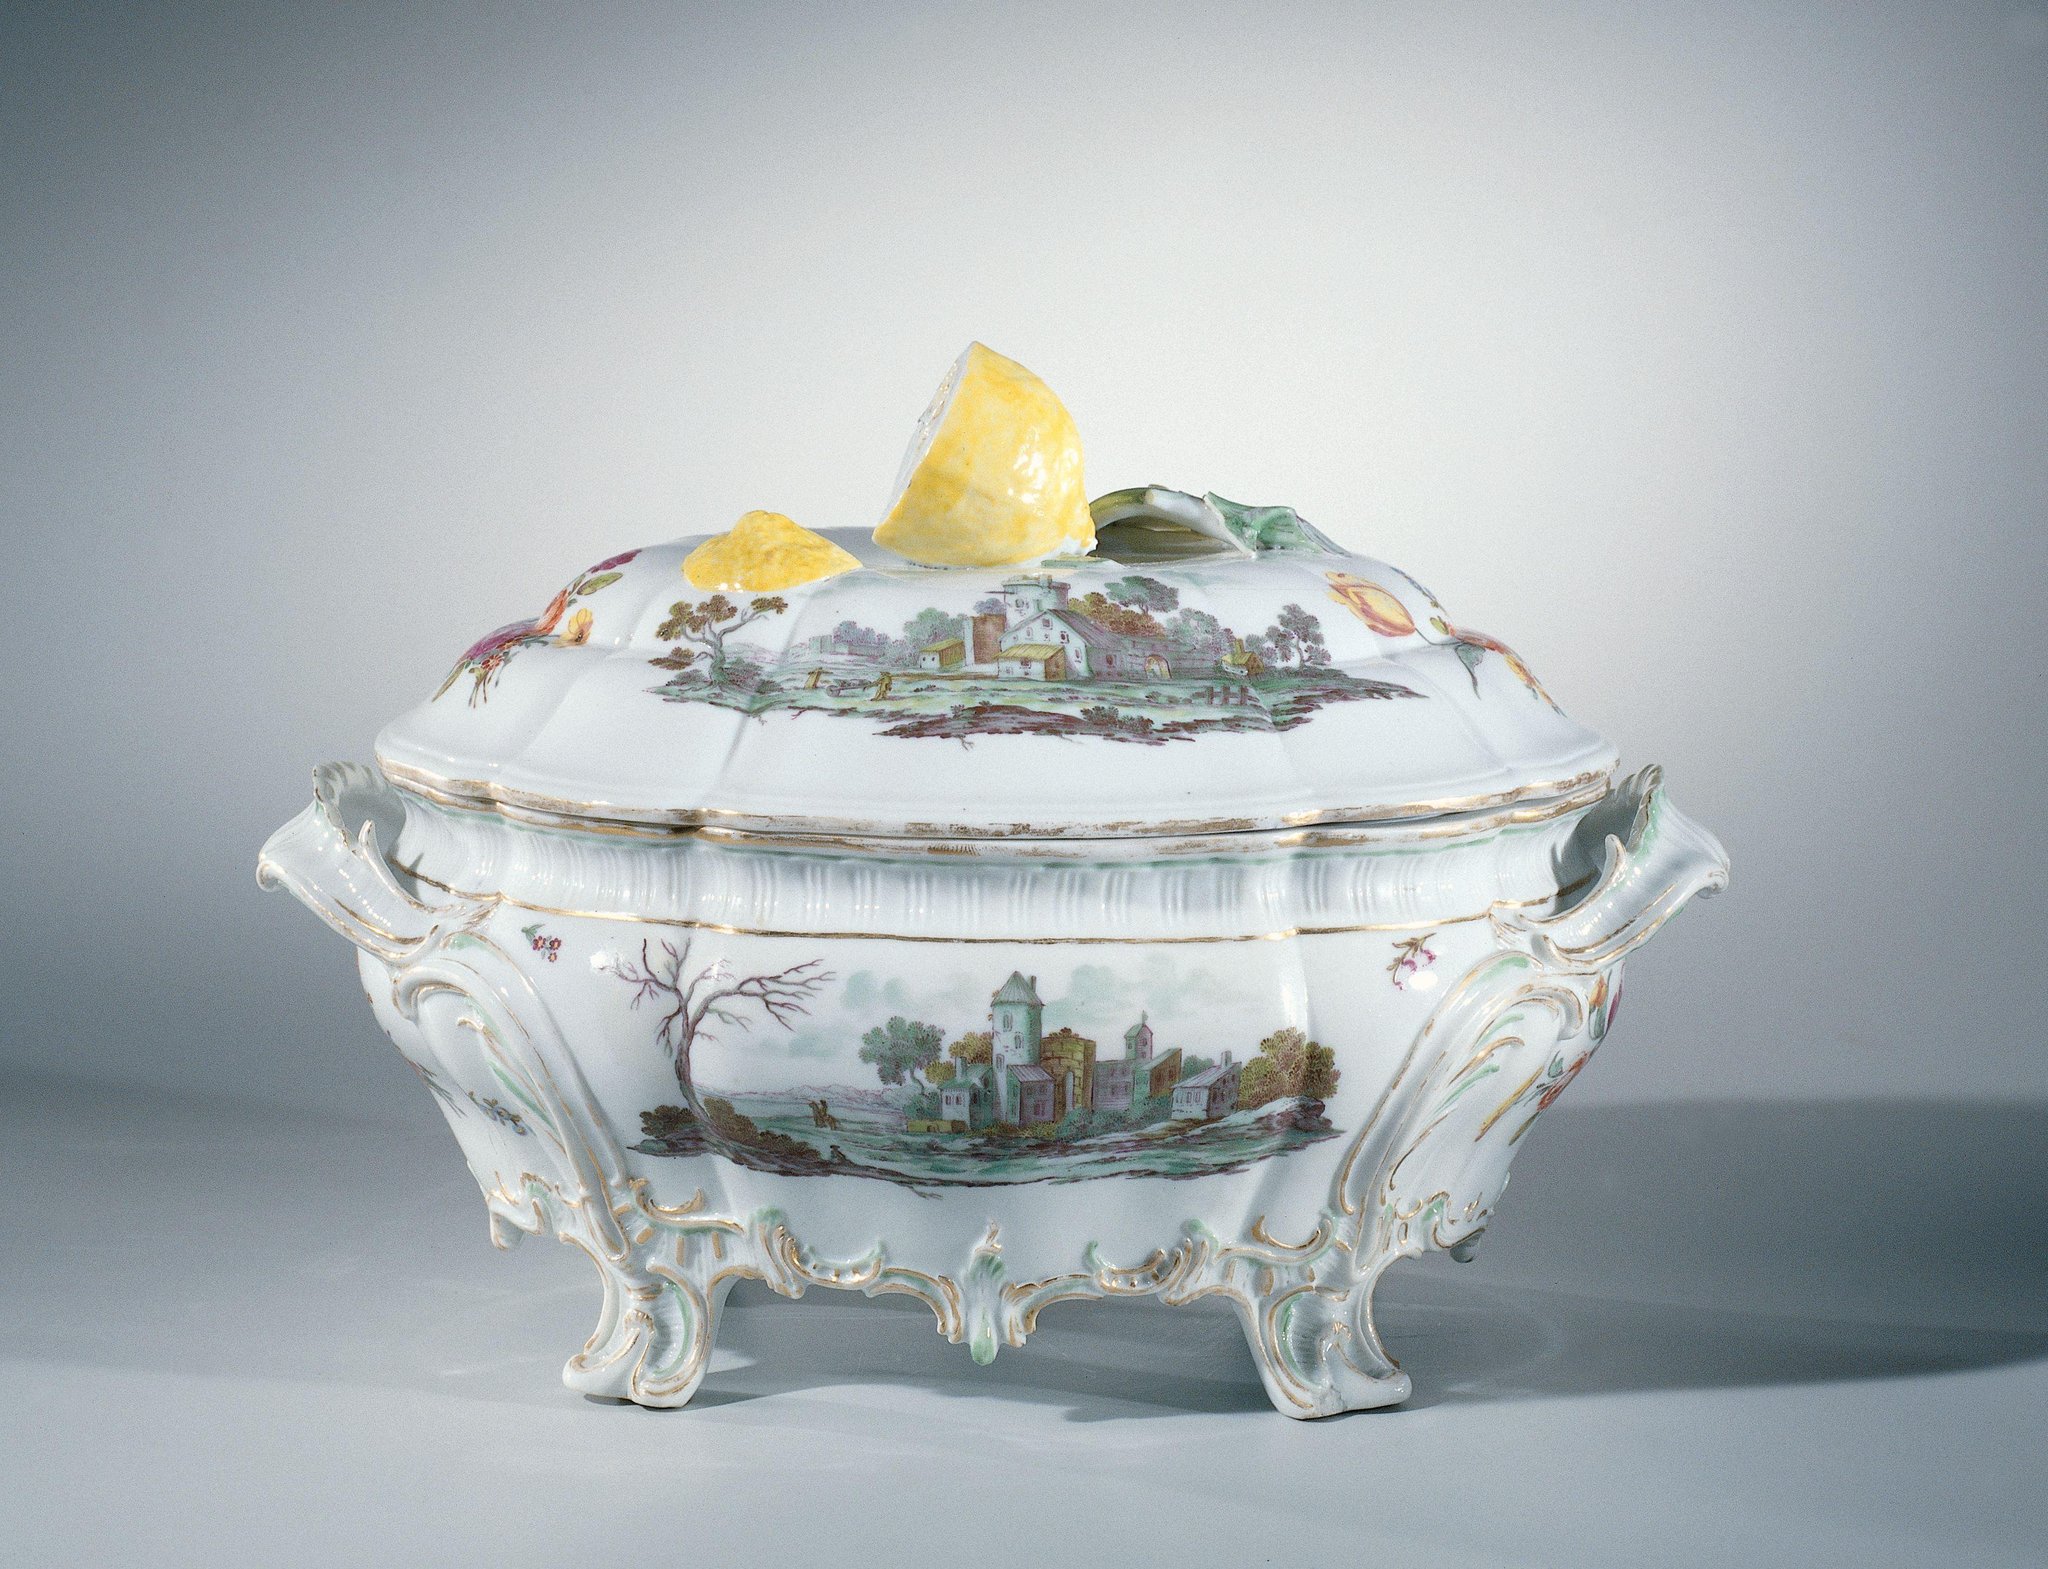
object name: lid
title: Cover of a tureen with landscapes and bouquets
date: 1760-1770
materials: glaze, gold, paint, porcelain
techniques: firing, forming, gilding, relief, vitrification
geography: nymphenburg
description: Ovale deksel van een terrine van porselein met een gelobde wand en rand, beschilderd op het glazuur in emailkleuren en goud. Versierd met tweemaal een landschap met boeren en wandelaars bij een dorp. Op de smalle zijden een boeket van verschillende bloemen. Dekselknop in de vorm van een fruittak (halve citroen).